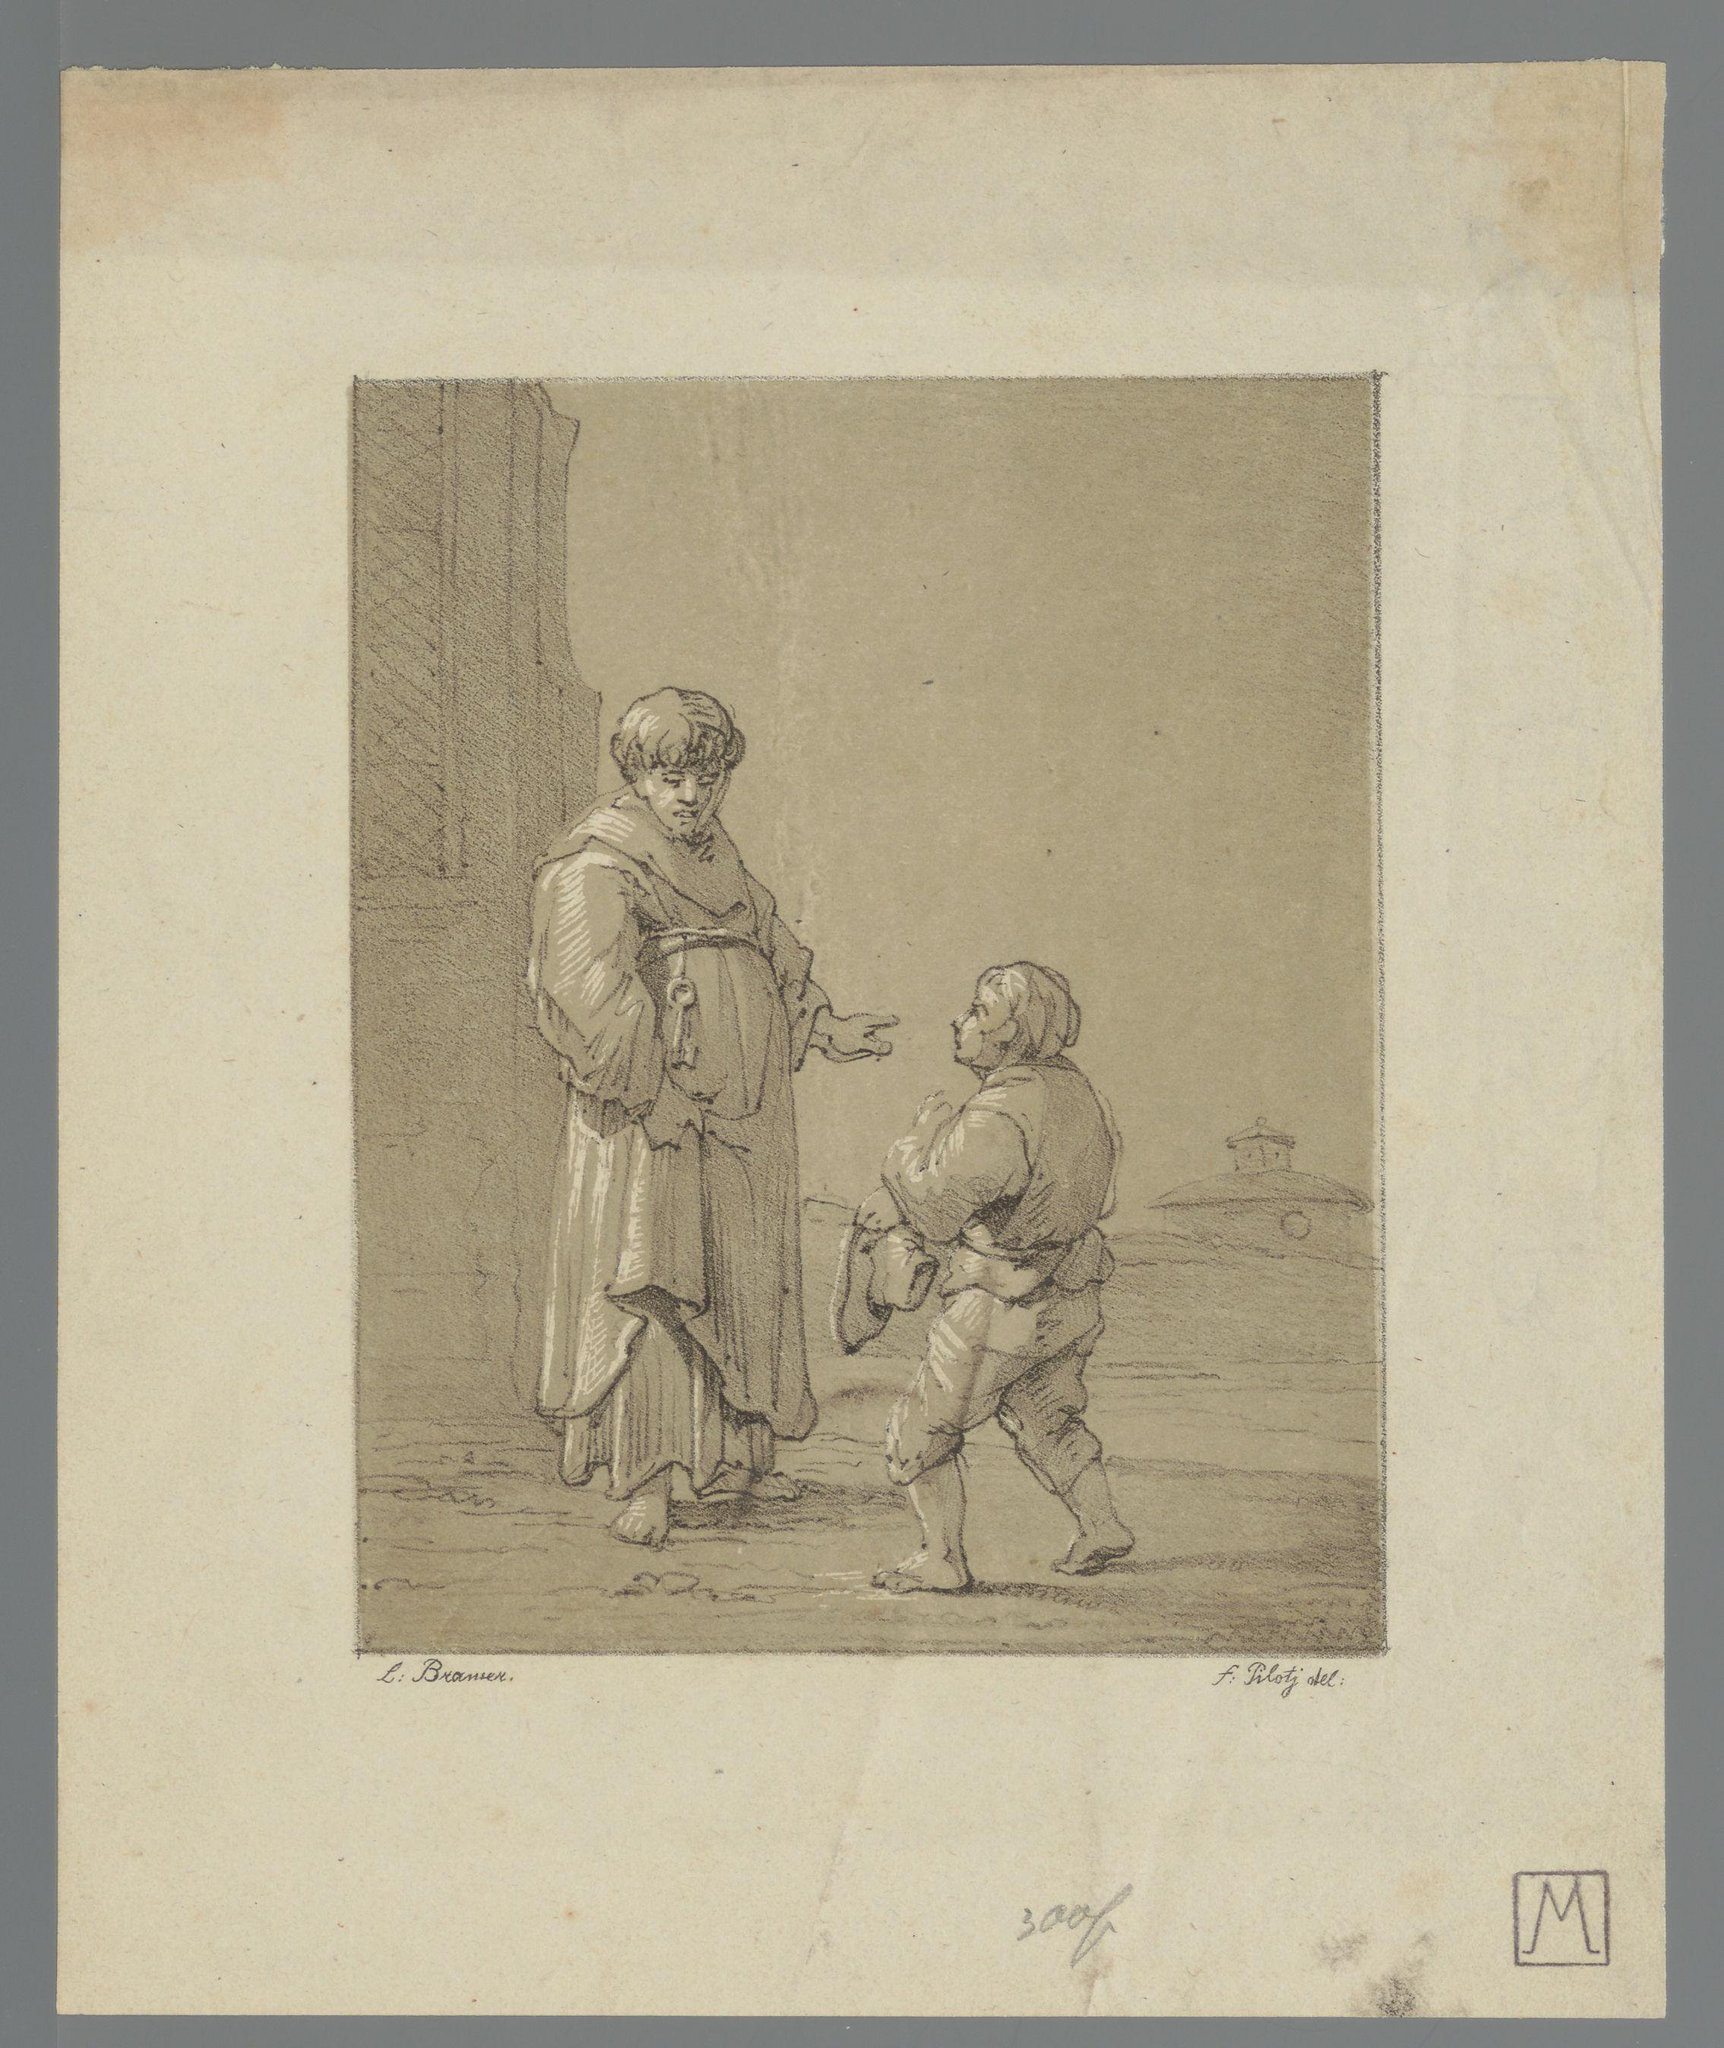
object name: print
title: Monnik wijst een figuur met hoed de weg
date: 1810-1816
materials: paper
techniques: tone lithography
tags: adult man (+ two persons), monk(s), friar(s), index finger forwards, pointing, indicating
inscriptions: mark: ‘M’ Lugt 1849a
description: Prent behoort tot de serie 'Les Oeuvres Lithographiques, choix de dessins d'après les grands maitres de toutes les Ecoles, tirées du Musée de S.M. le roi de Bavière par Strixner, Piloty et Cie'. Deze serie werd door J. Stunz in München in 72 delen van elk zes bladen gepubliceerd tussen 1810 en 1816; in totaal 432 prenten.